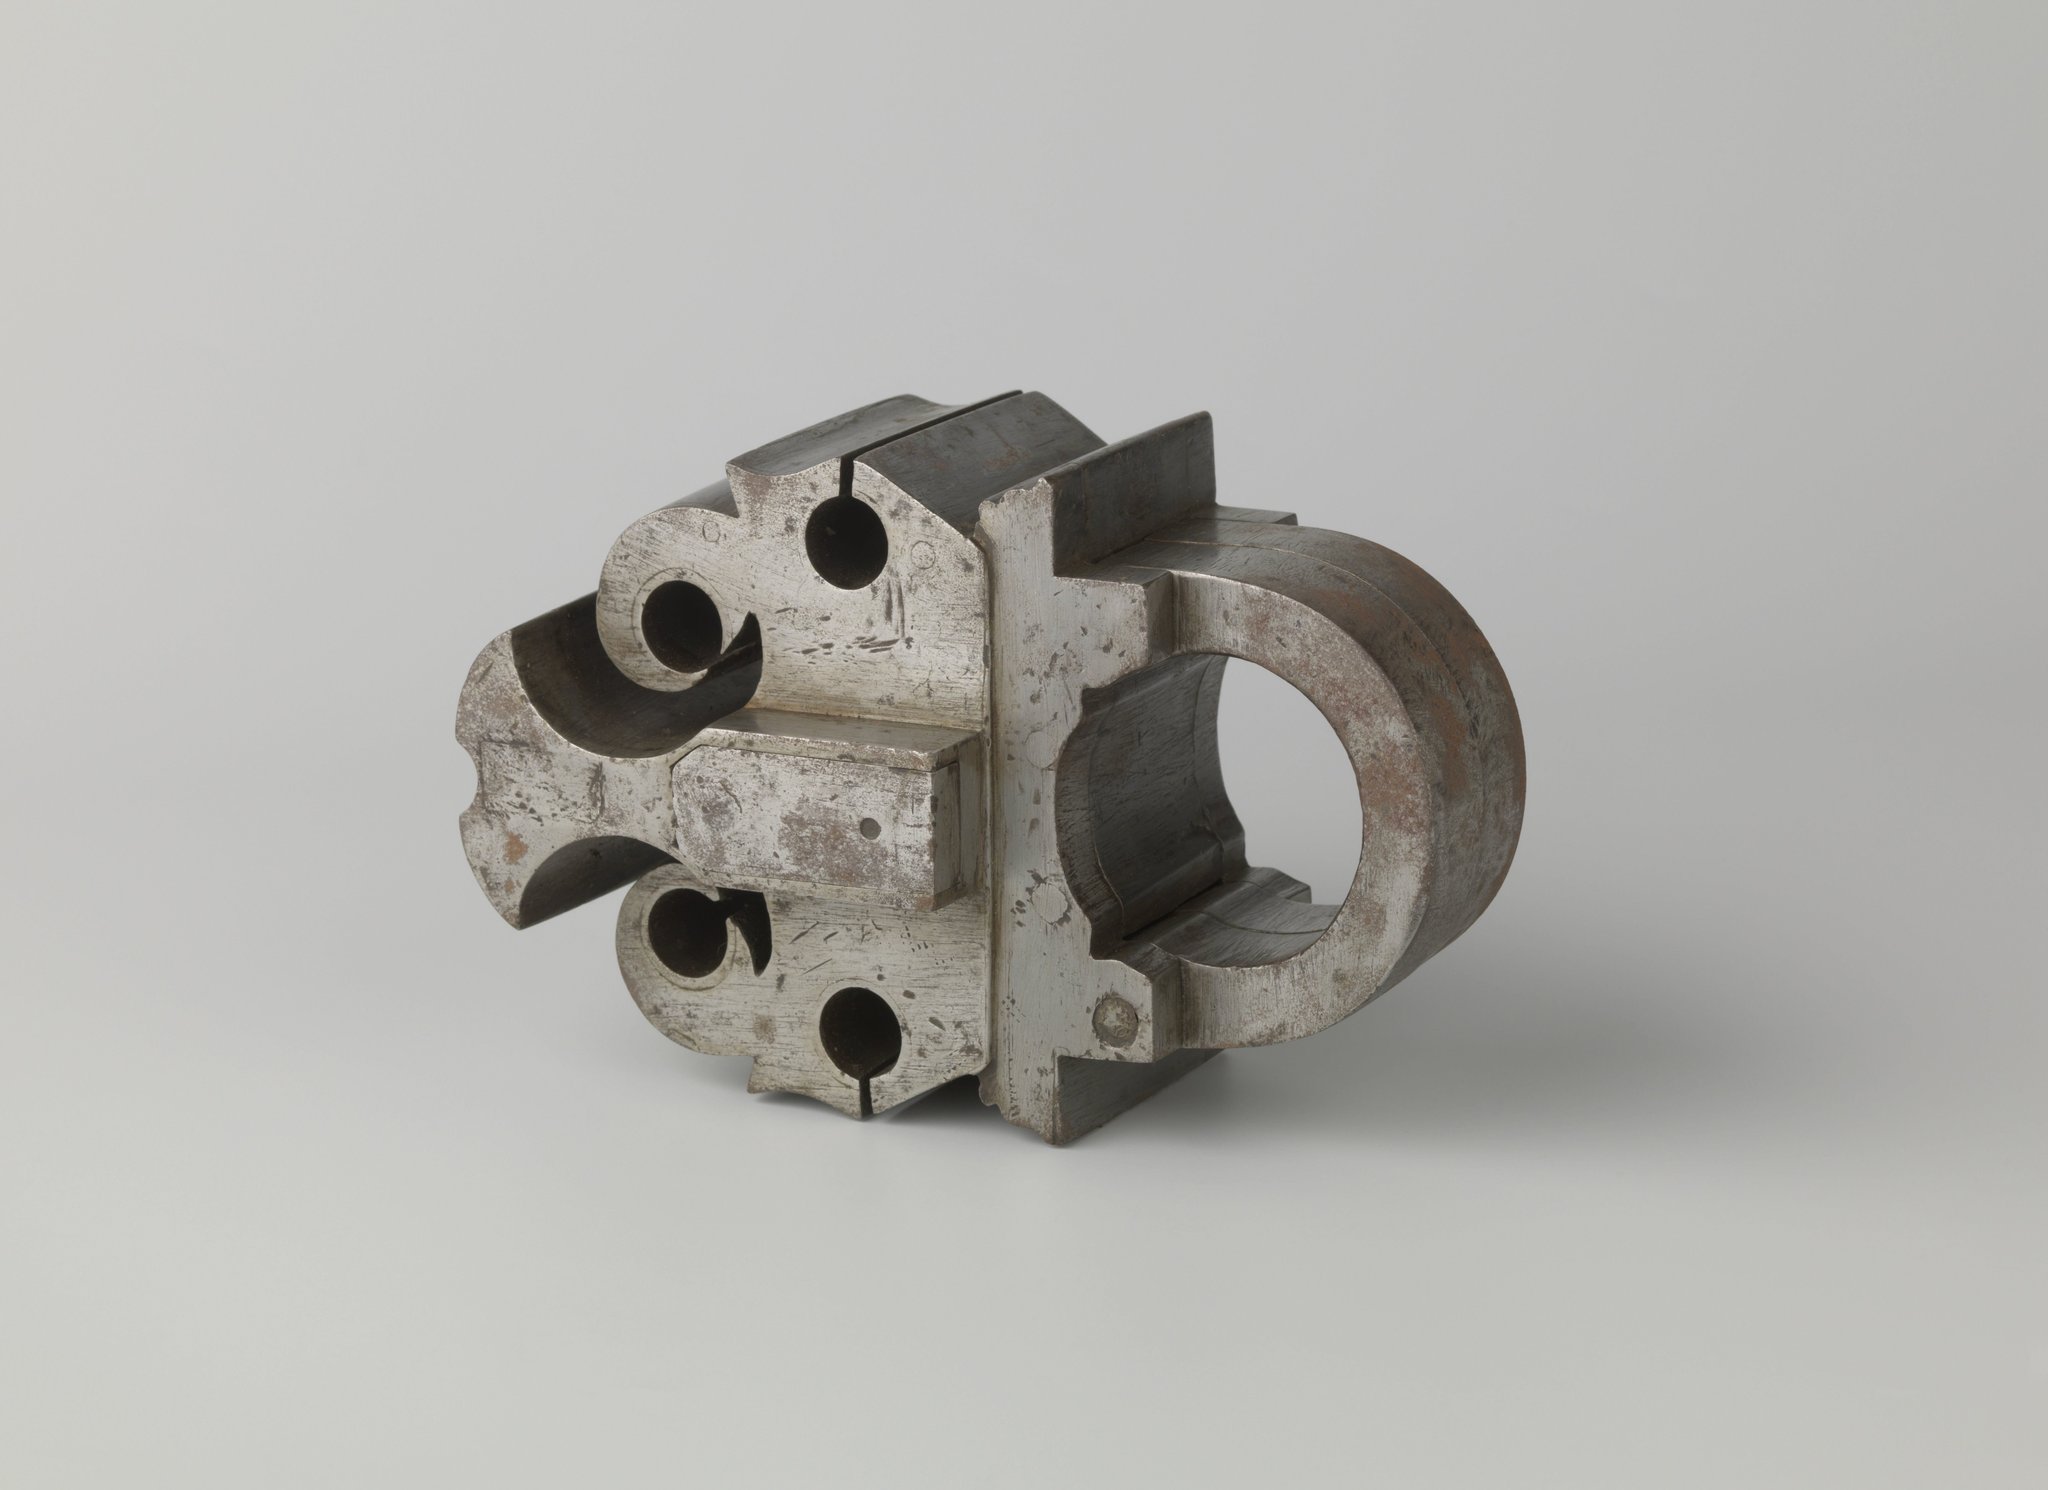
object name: padlock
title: Een hangslot met twee inslagen en een sleutel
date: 1590-1610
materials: iron